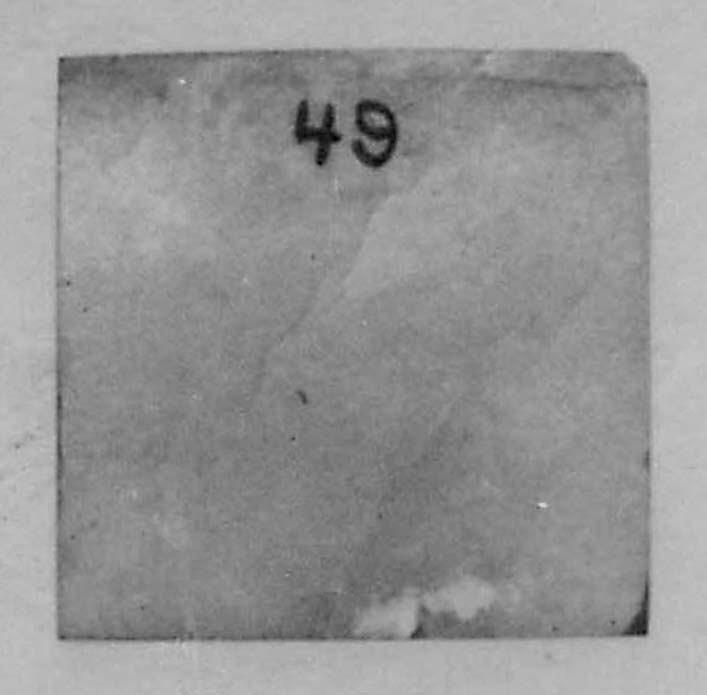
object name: fragment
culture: tibetan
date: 1902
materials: jade